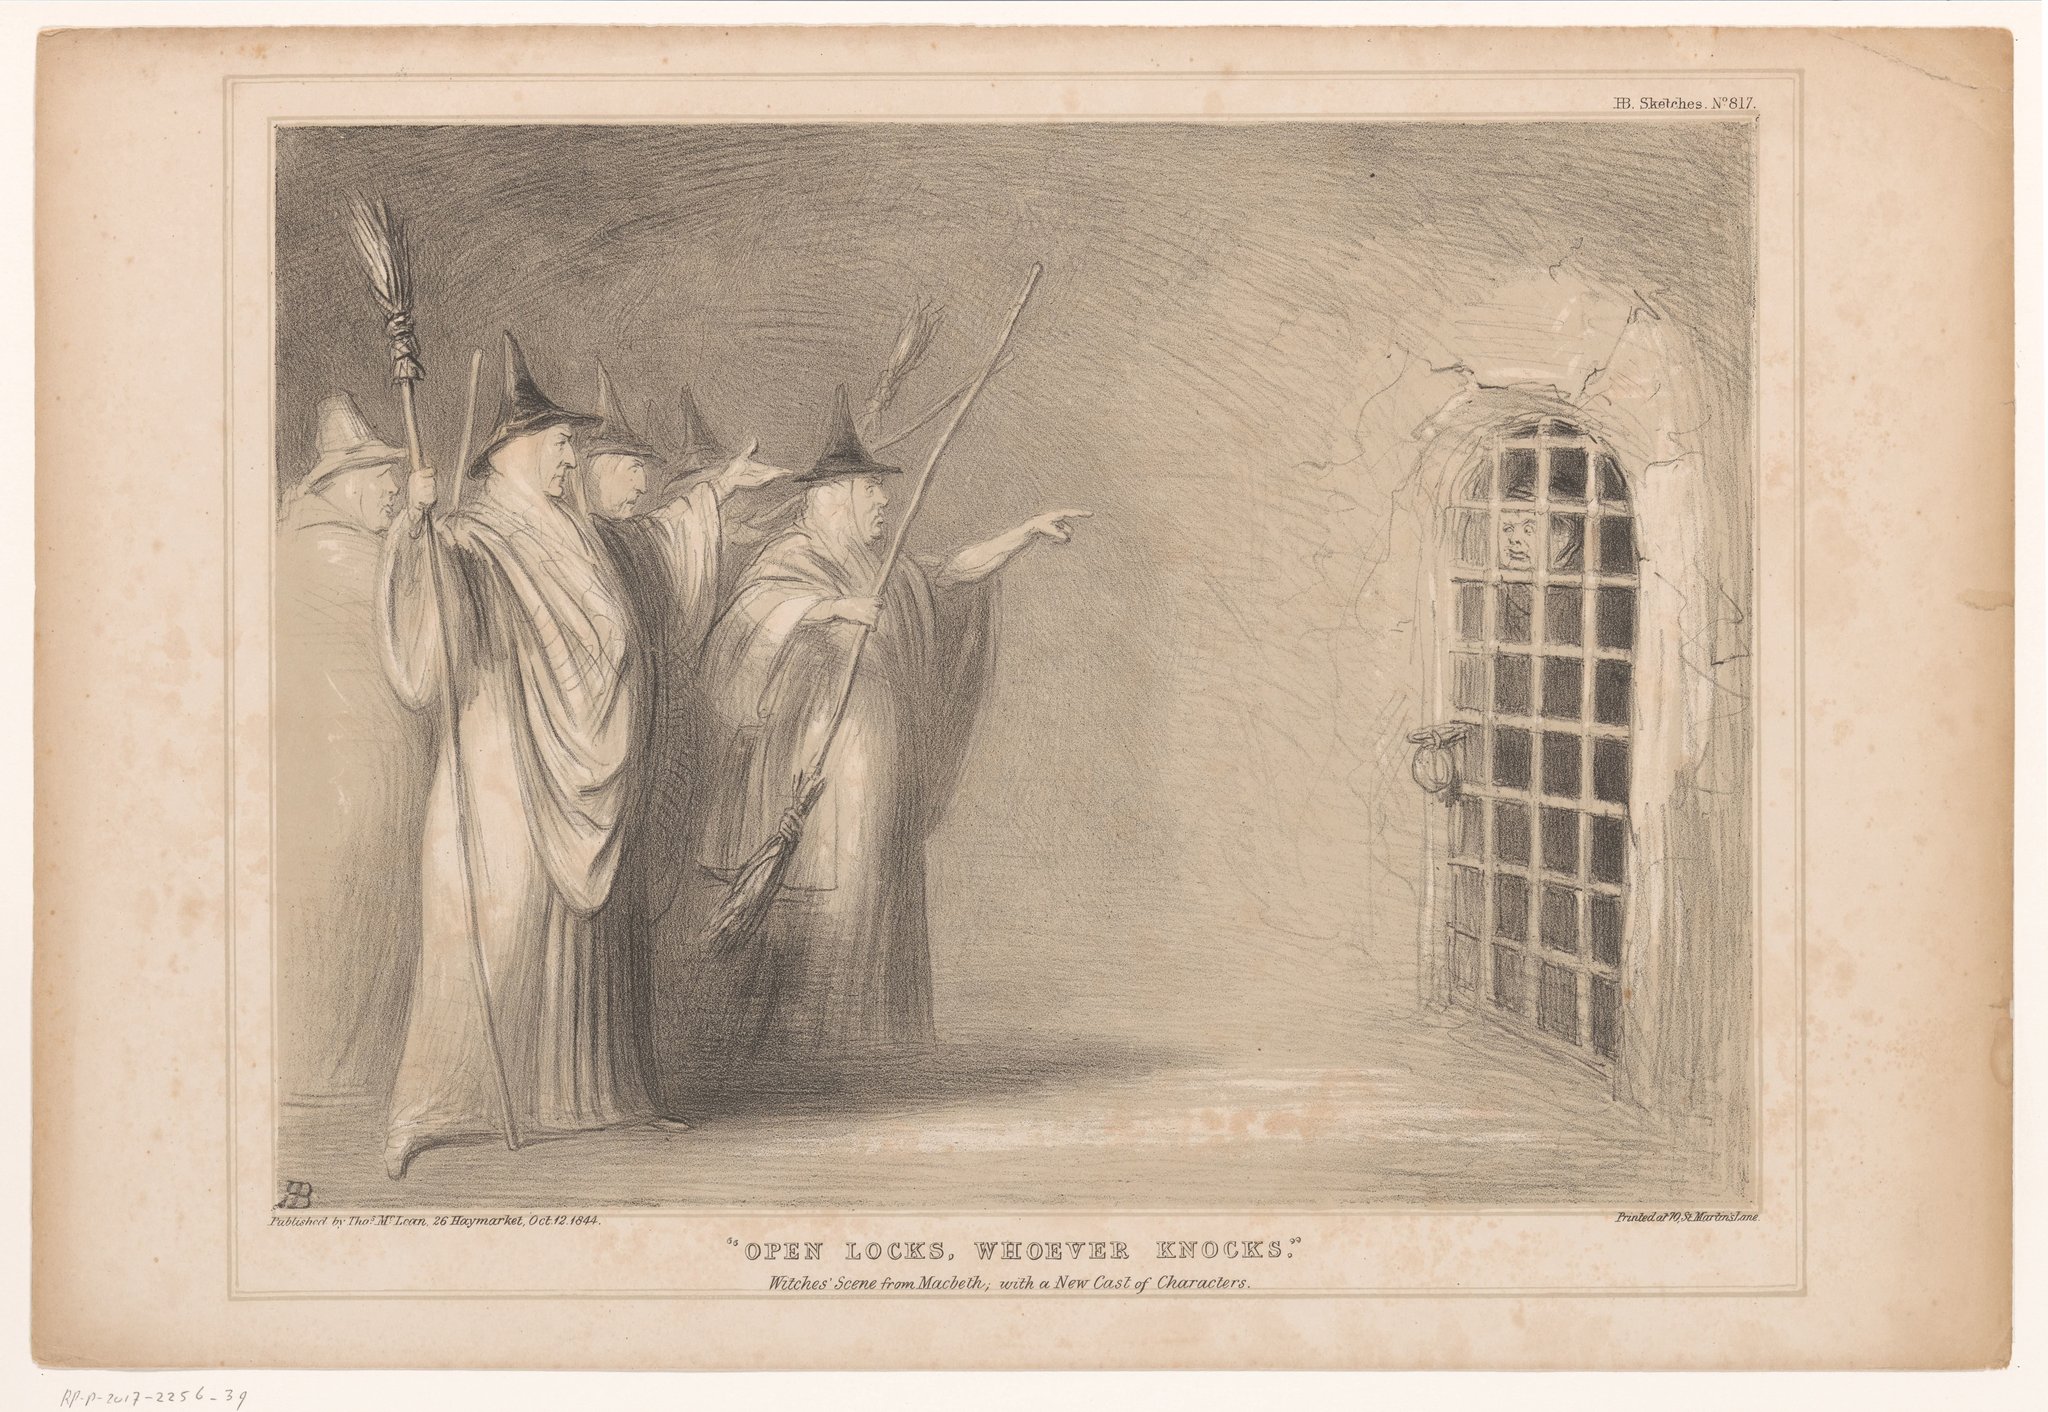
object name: print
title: Spotprent met Daniel O'Connell in de gevangenis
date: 1844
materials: paper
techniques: tone lithography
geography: england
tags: prison, jail, groups of witches, (scenes from) specific works of literature (with author, title), political caricatures and satires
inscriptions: stamp: ‘HB Subscribers Copy’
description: Spotprent met Daniel O'Connell in de gevangenis en de drie heksen uit Shakespeares Macbeth. Uitgegeven als nr. 817 in de serie HB Sketches.